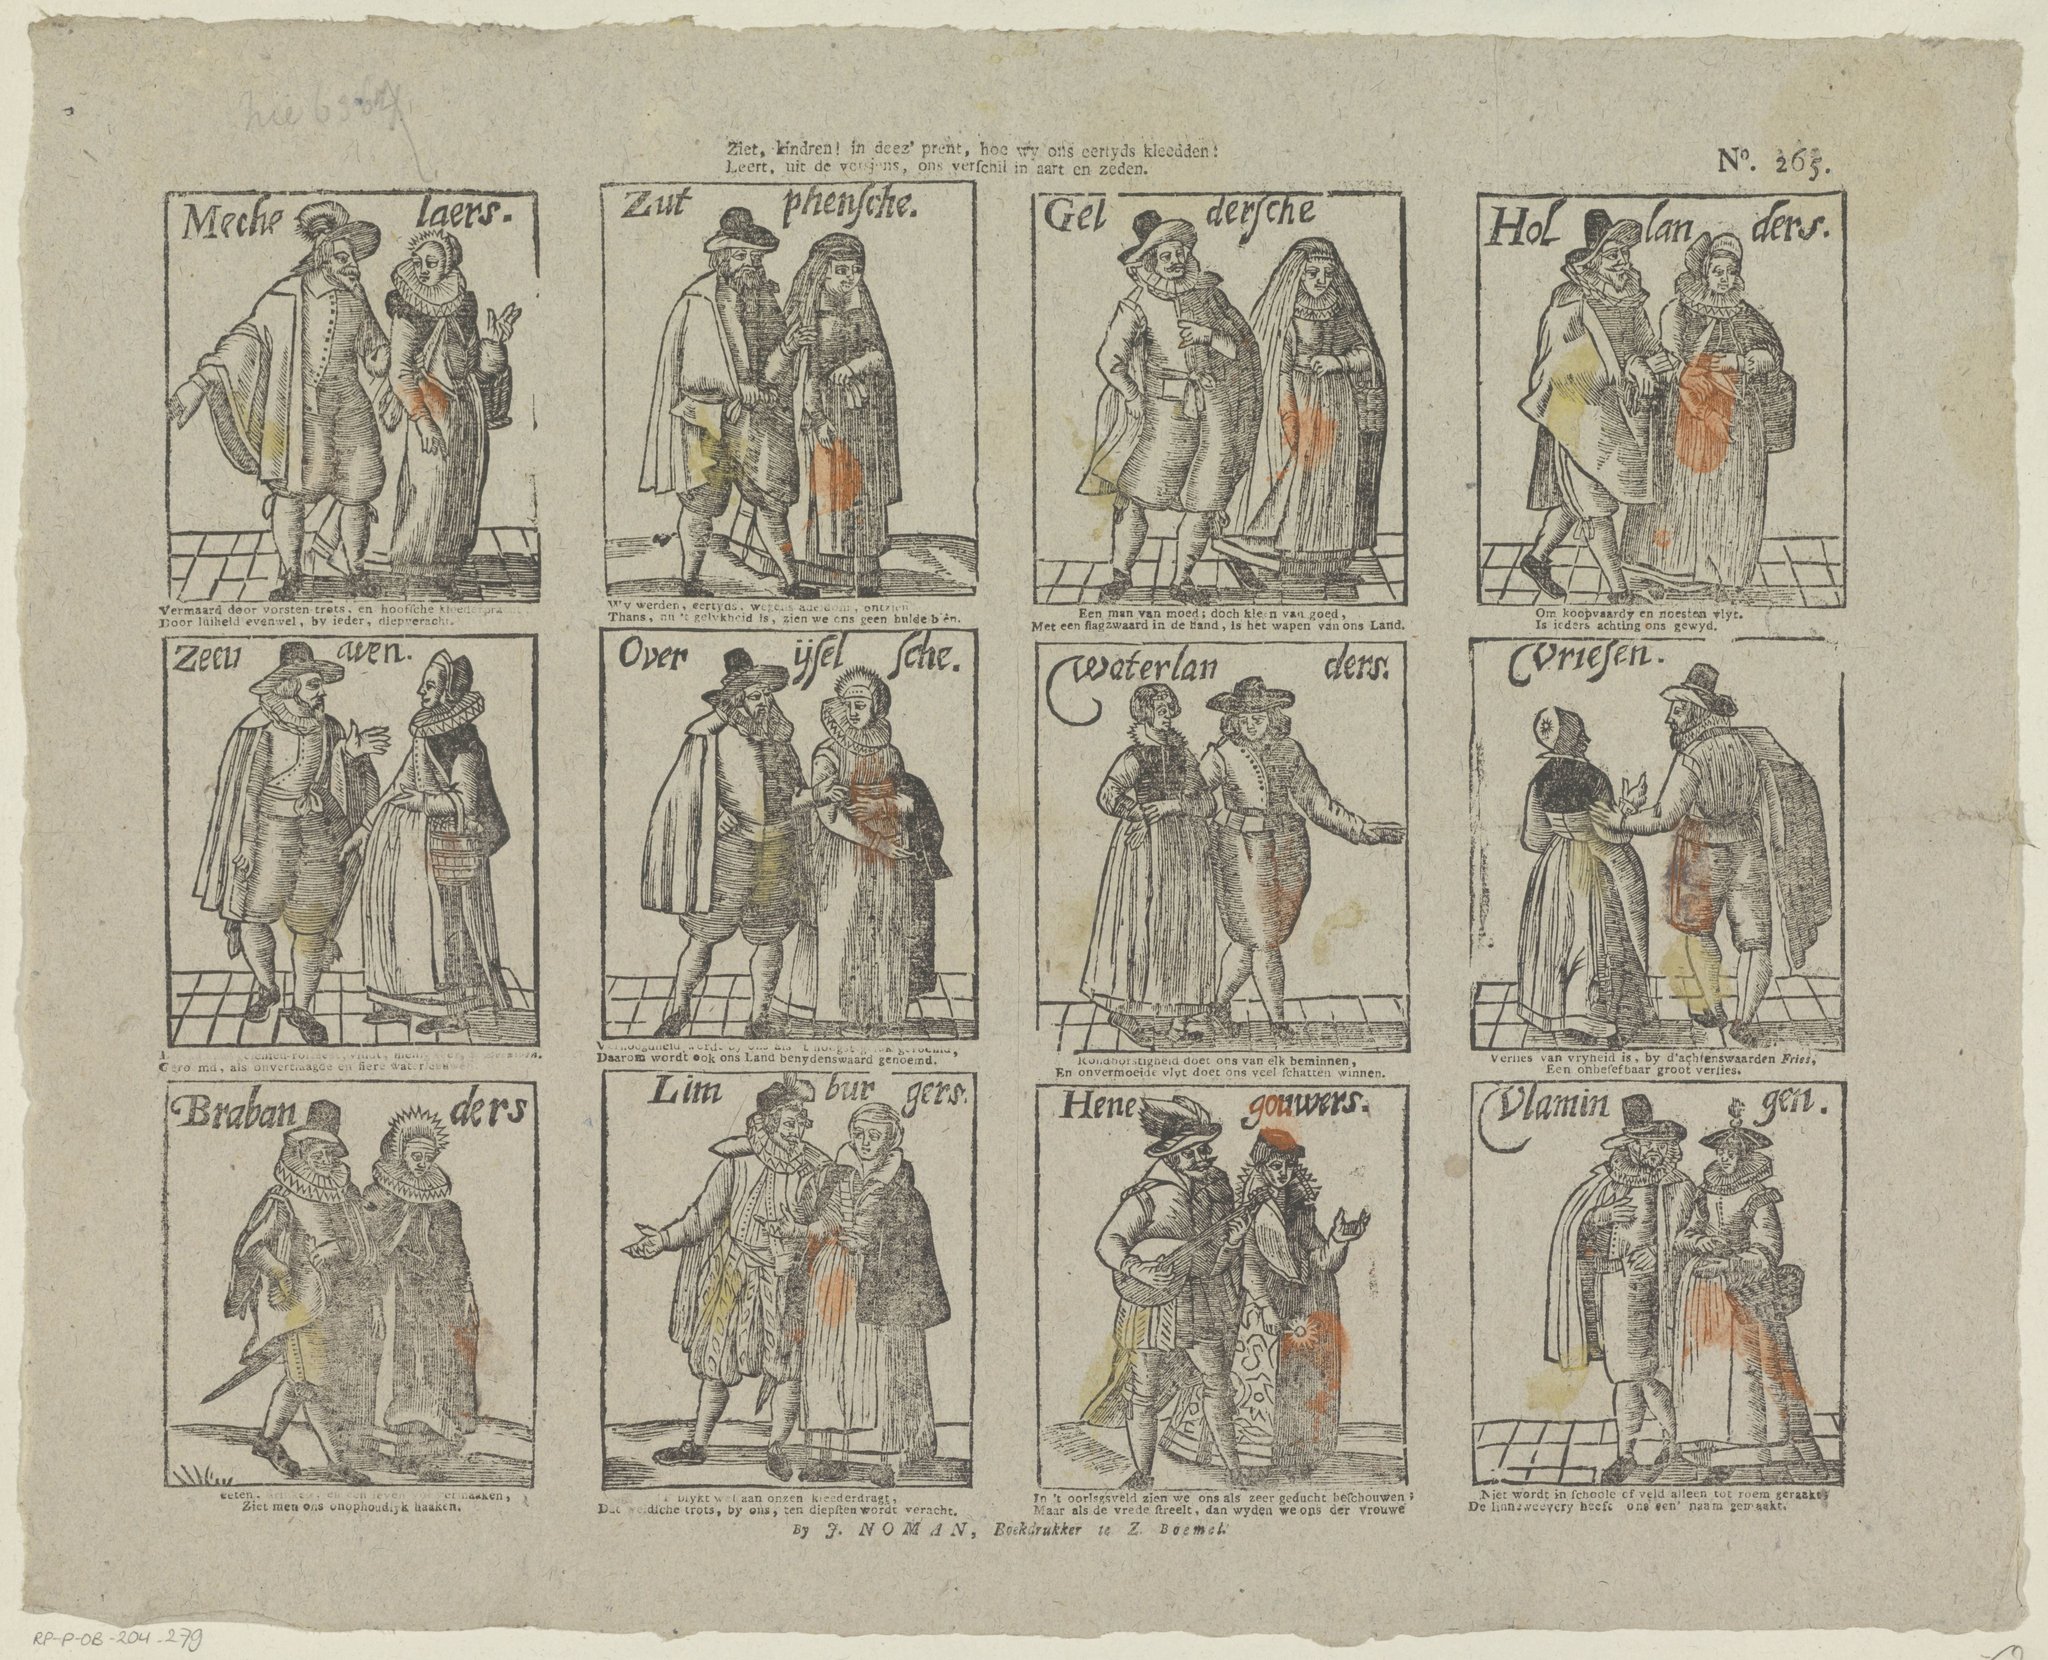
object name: print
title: Ziet, kindren! in deez' prent, hoe wy ons eertyds kleedden: / Leert, uit de versjens, ons verschil in aart en zeden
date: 1806-1830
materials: paper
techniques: colour, letterpress printing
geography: zaltbommel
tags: europeans, historical costume, folk costume, regional costume, zeeland, mechelen, brabant, gelderland, holland, henegouwen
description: Blad met 12 voorstellingen van paren uit verschillende streken in diverse klederdrachten. Onder elke afbeelding een tweeregelig vers. In elke afbeelding de naam van de streek of provincie waar het paar vandaan komt. Genummerd rechtsboven: No. 265.